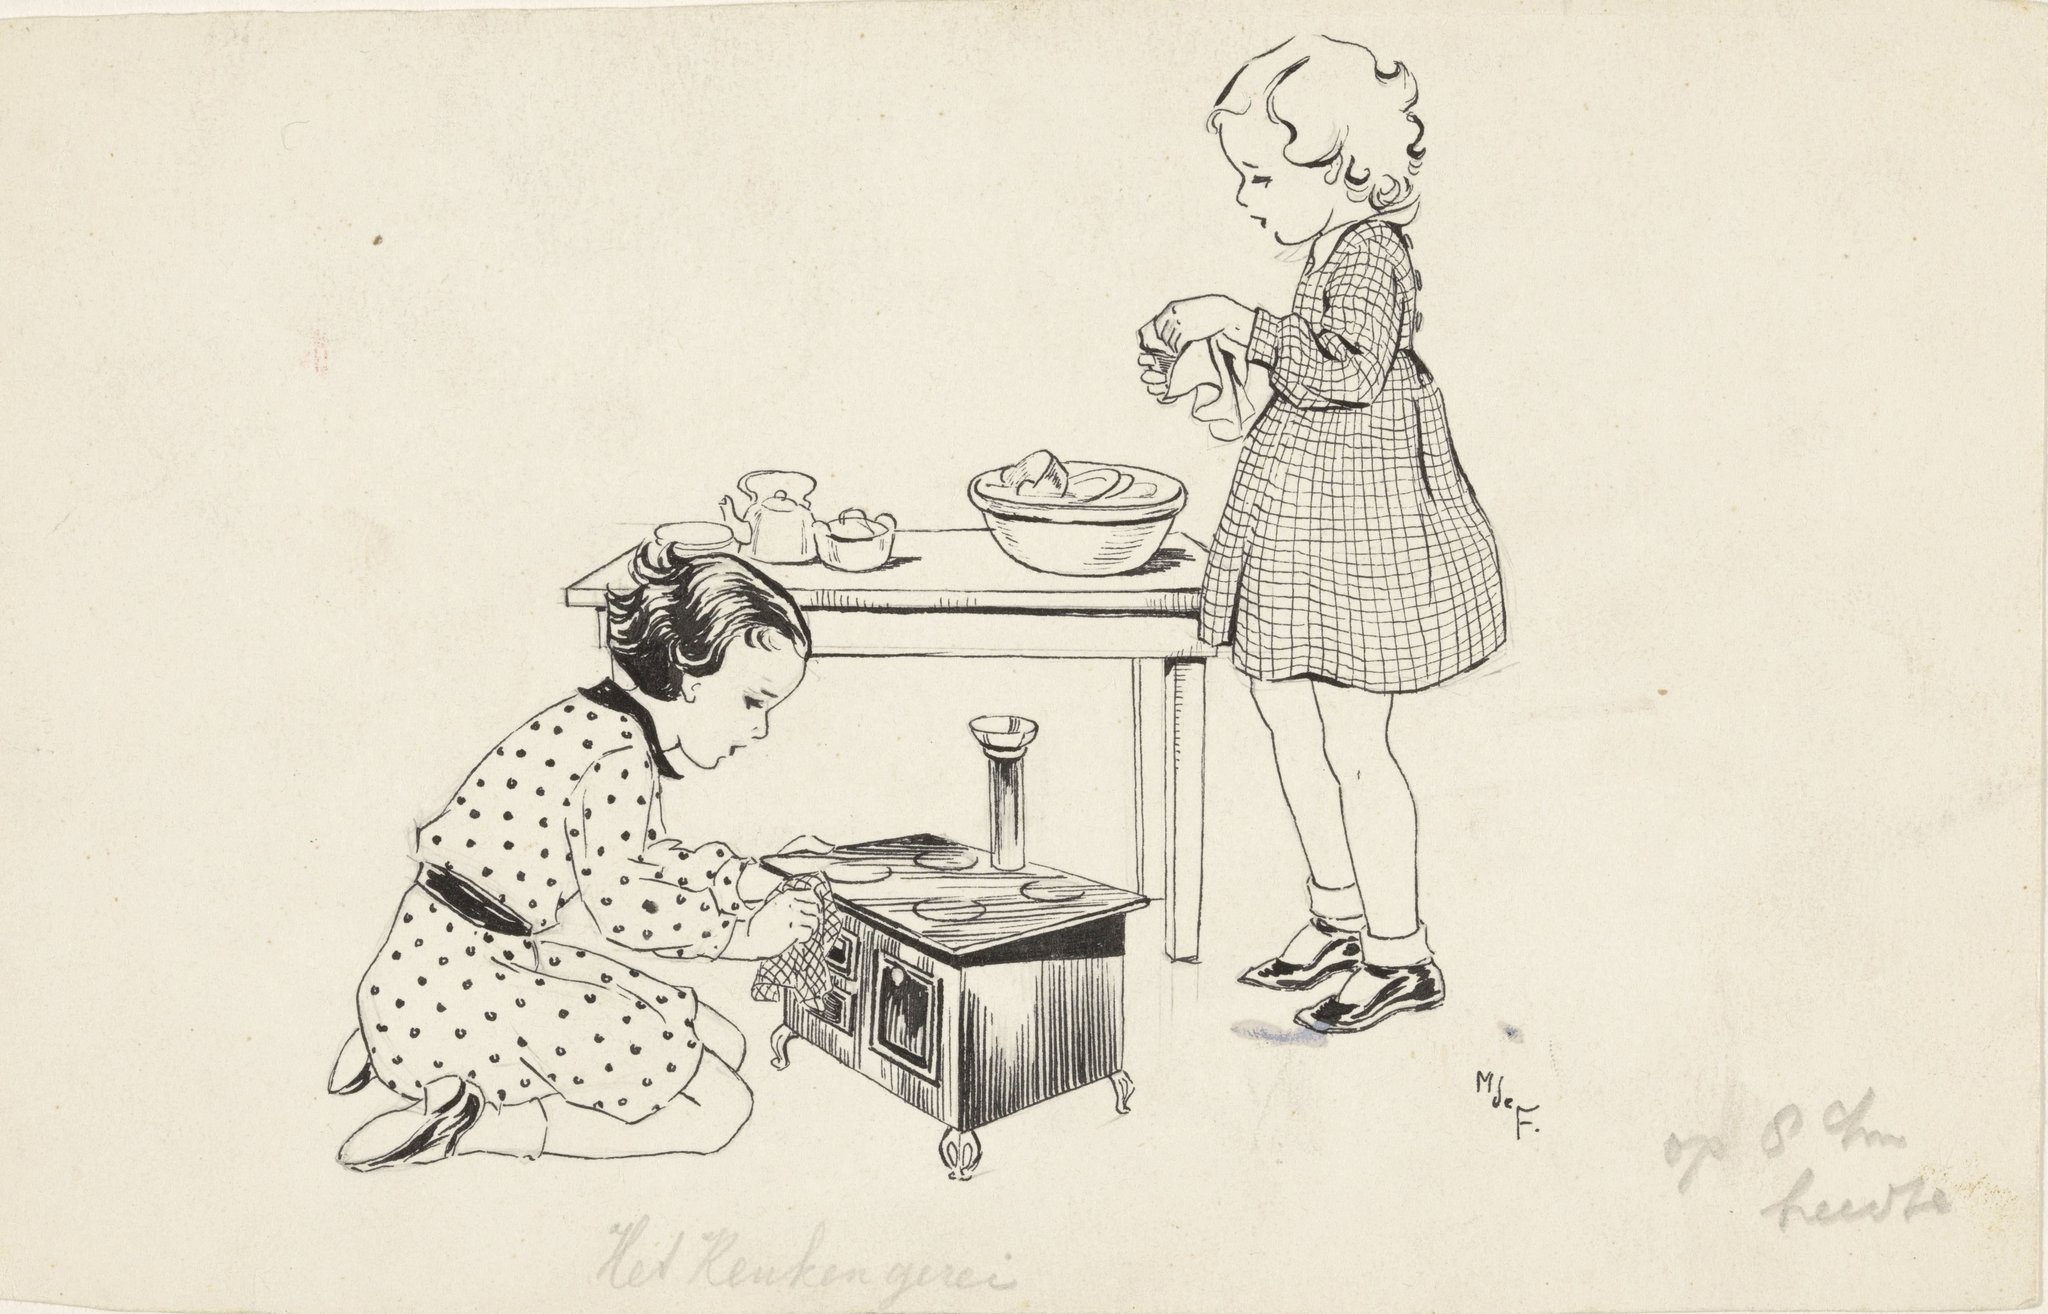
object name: drawing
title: Twee meisjes spelend met een speelgoedfornuis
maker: miep de feijter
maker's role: draughtsman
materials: ink, paper, pencil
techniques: pen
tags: toy oven or stove, girl (child between toddler and youth)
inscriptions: collector's mark: Lugt 2228a, signature: ‘M/ de/ F.’, annotation: ‘Het Keuken gerei’, :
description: Twee meisjes spelen met een speelgoedfornuis met oven. Eén van de meisjes zit op de knieën het fornuis te poetsen. Het andere meisje staat met een doek naast een lage tafel waarop onder andere een theepot, schoteltjes en een kom staan.